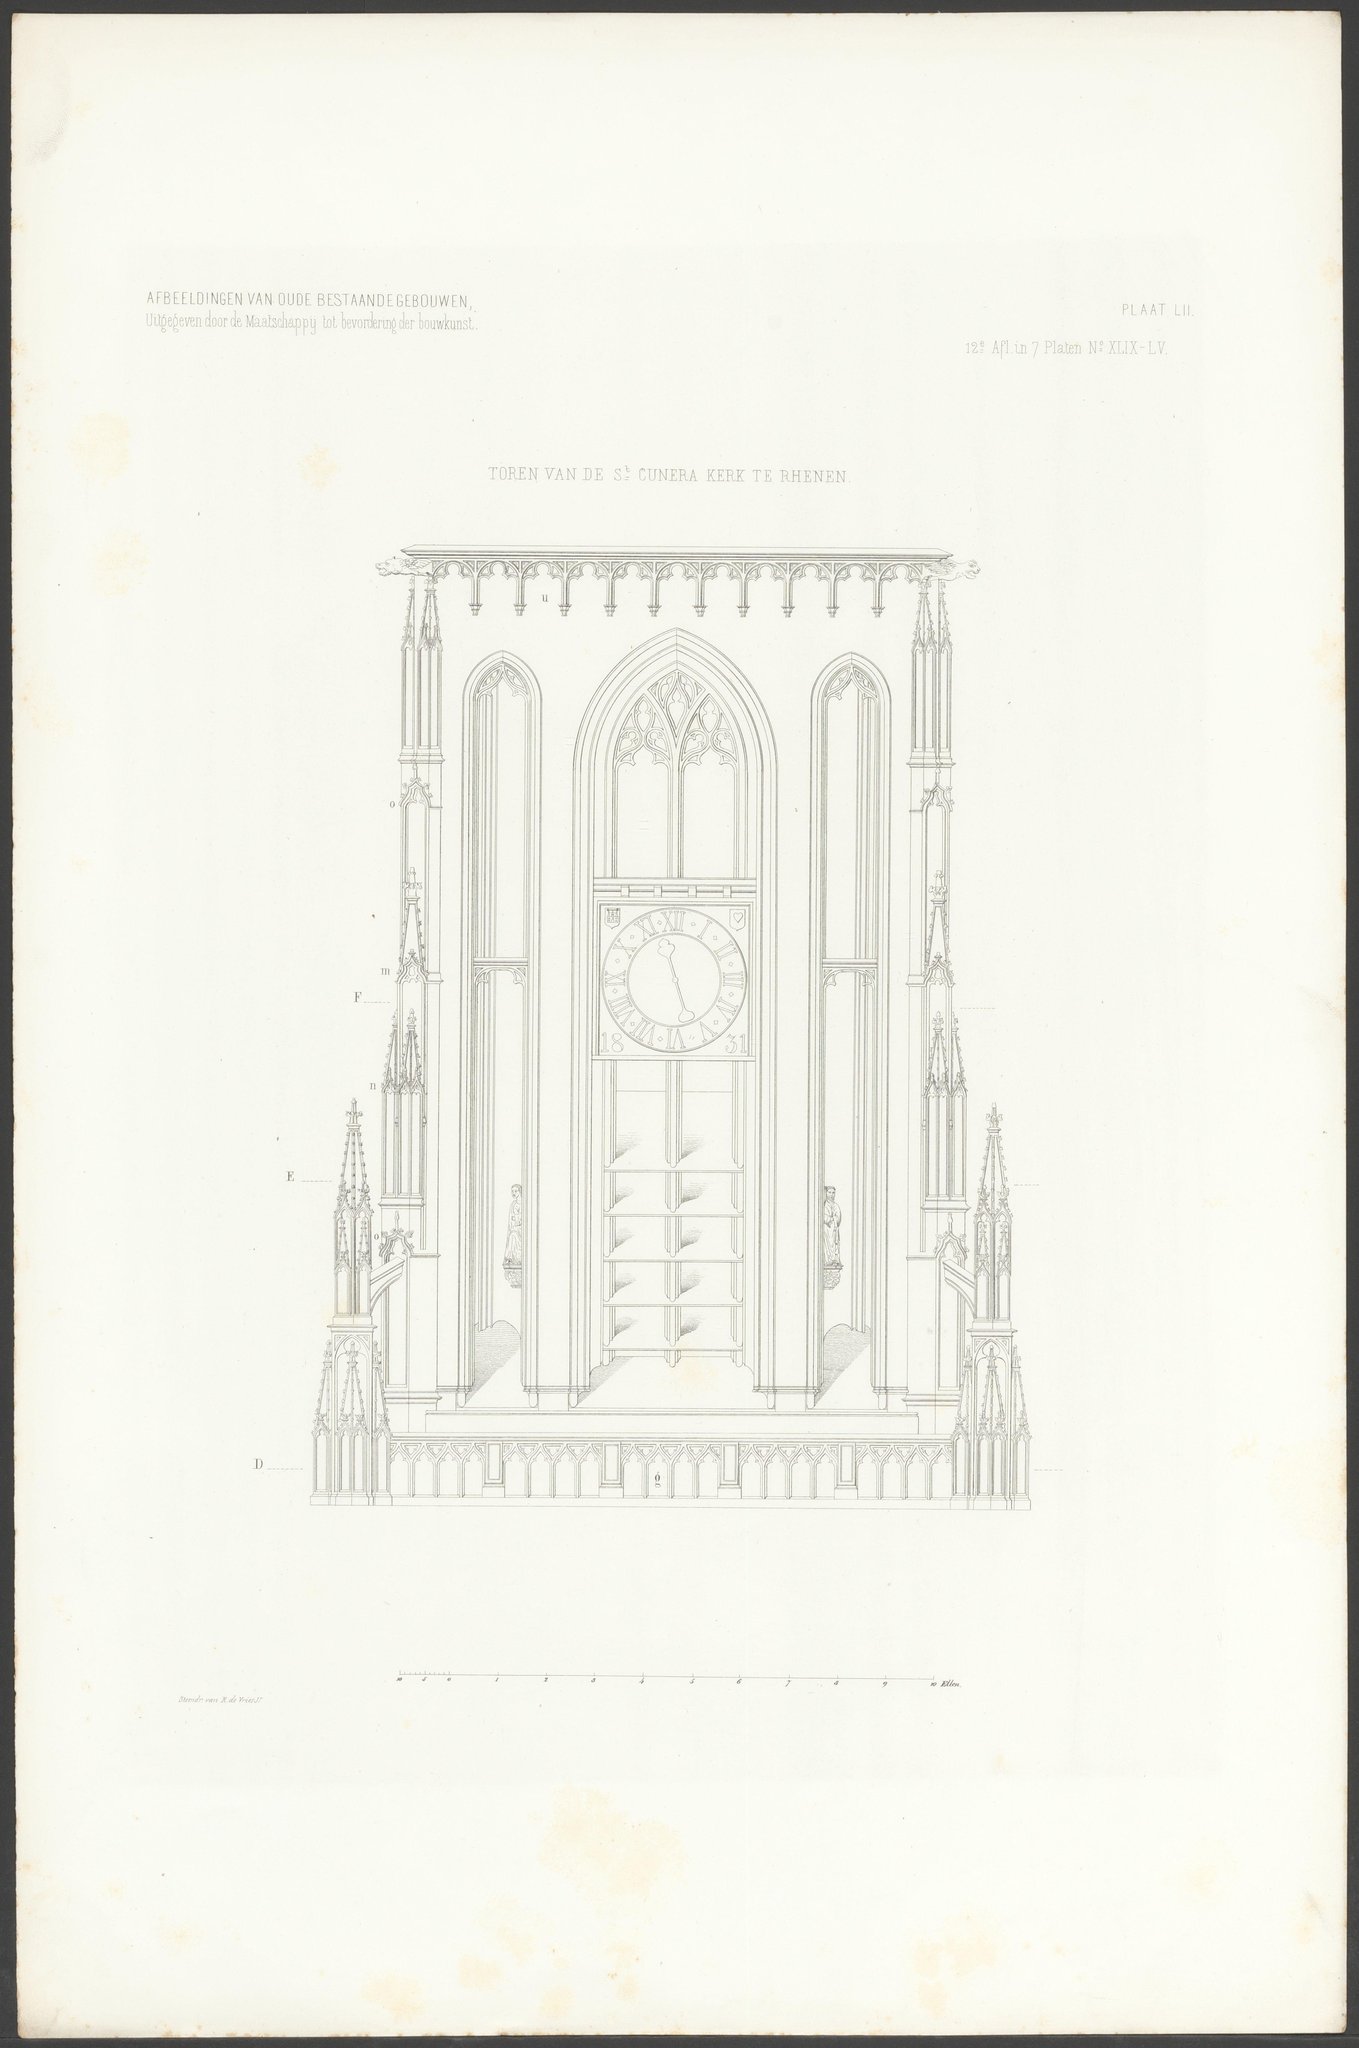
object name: print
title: Afbeeldingen van oude bestaande gebouwen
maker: ruurt de vries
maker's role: print maker, printer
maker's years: 1813-1874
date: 1854-1874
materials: paper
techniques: lithograph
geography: amersfoort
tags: parts of church exterior and annexes: tower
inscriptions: collector's mark: Lugt 1641, collector's mark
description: Aanzicht van de toren van de Cunerakerk te Rhenen. Onderaan een schaalstok. Architectuurvoorstelling. Plaat LII. Onderwerpsrubrieken binnen de Atlas Zeden en Gewoonten: Kerk en kerkwezen & Armwezen en liefdadige instellingen; Kerkgebouwen elders. M-U.